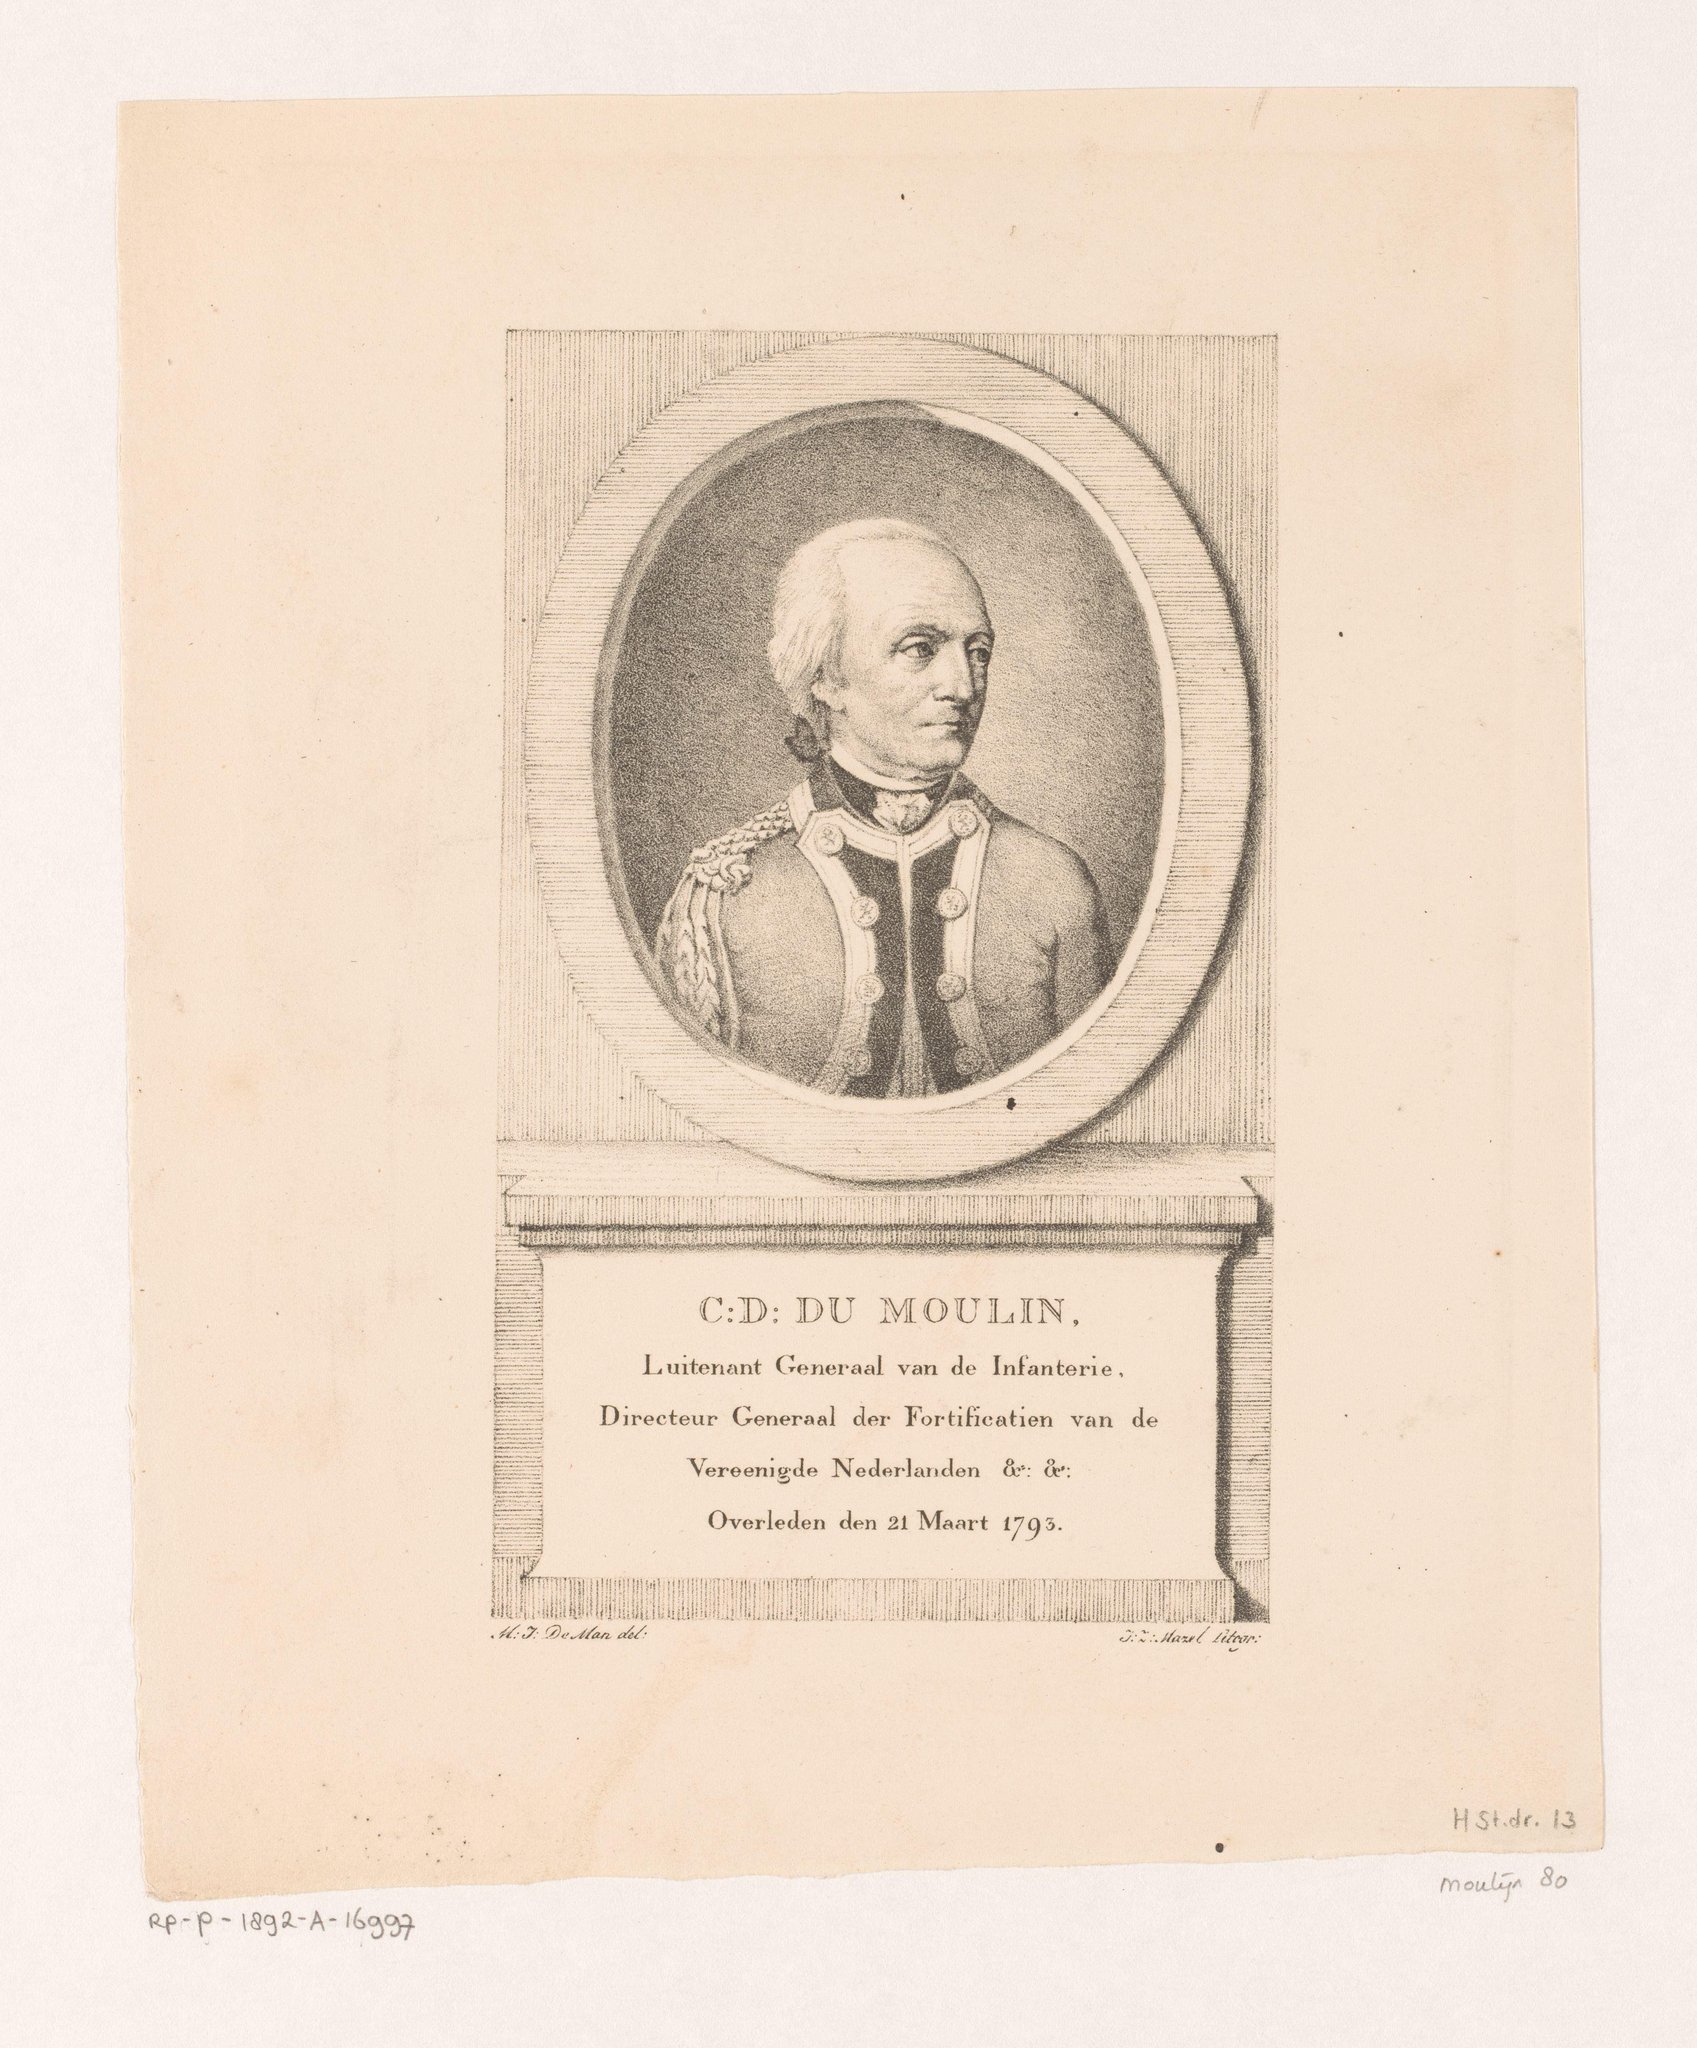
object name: print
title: Portret van Charles Diederik du Moulin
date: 1820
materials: paper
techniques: lithograph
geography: the hague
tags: historical persons (+ (full) bust portrait)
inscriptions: collector's mark: Lugt 2228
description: De geportretteerde draagt een militair uniform en is afgebeeld in een ovaal, staande op een plint met opschrift.